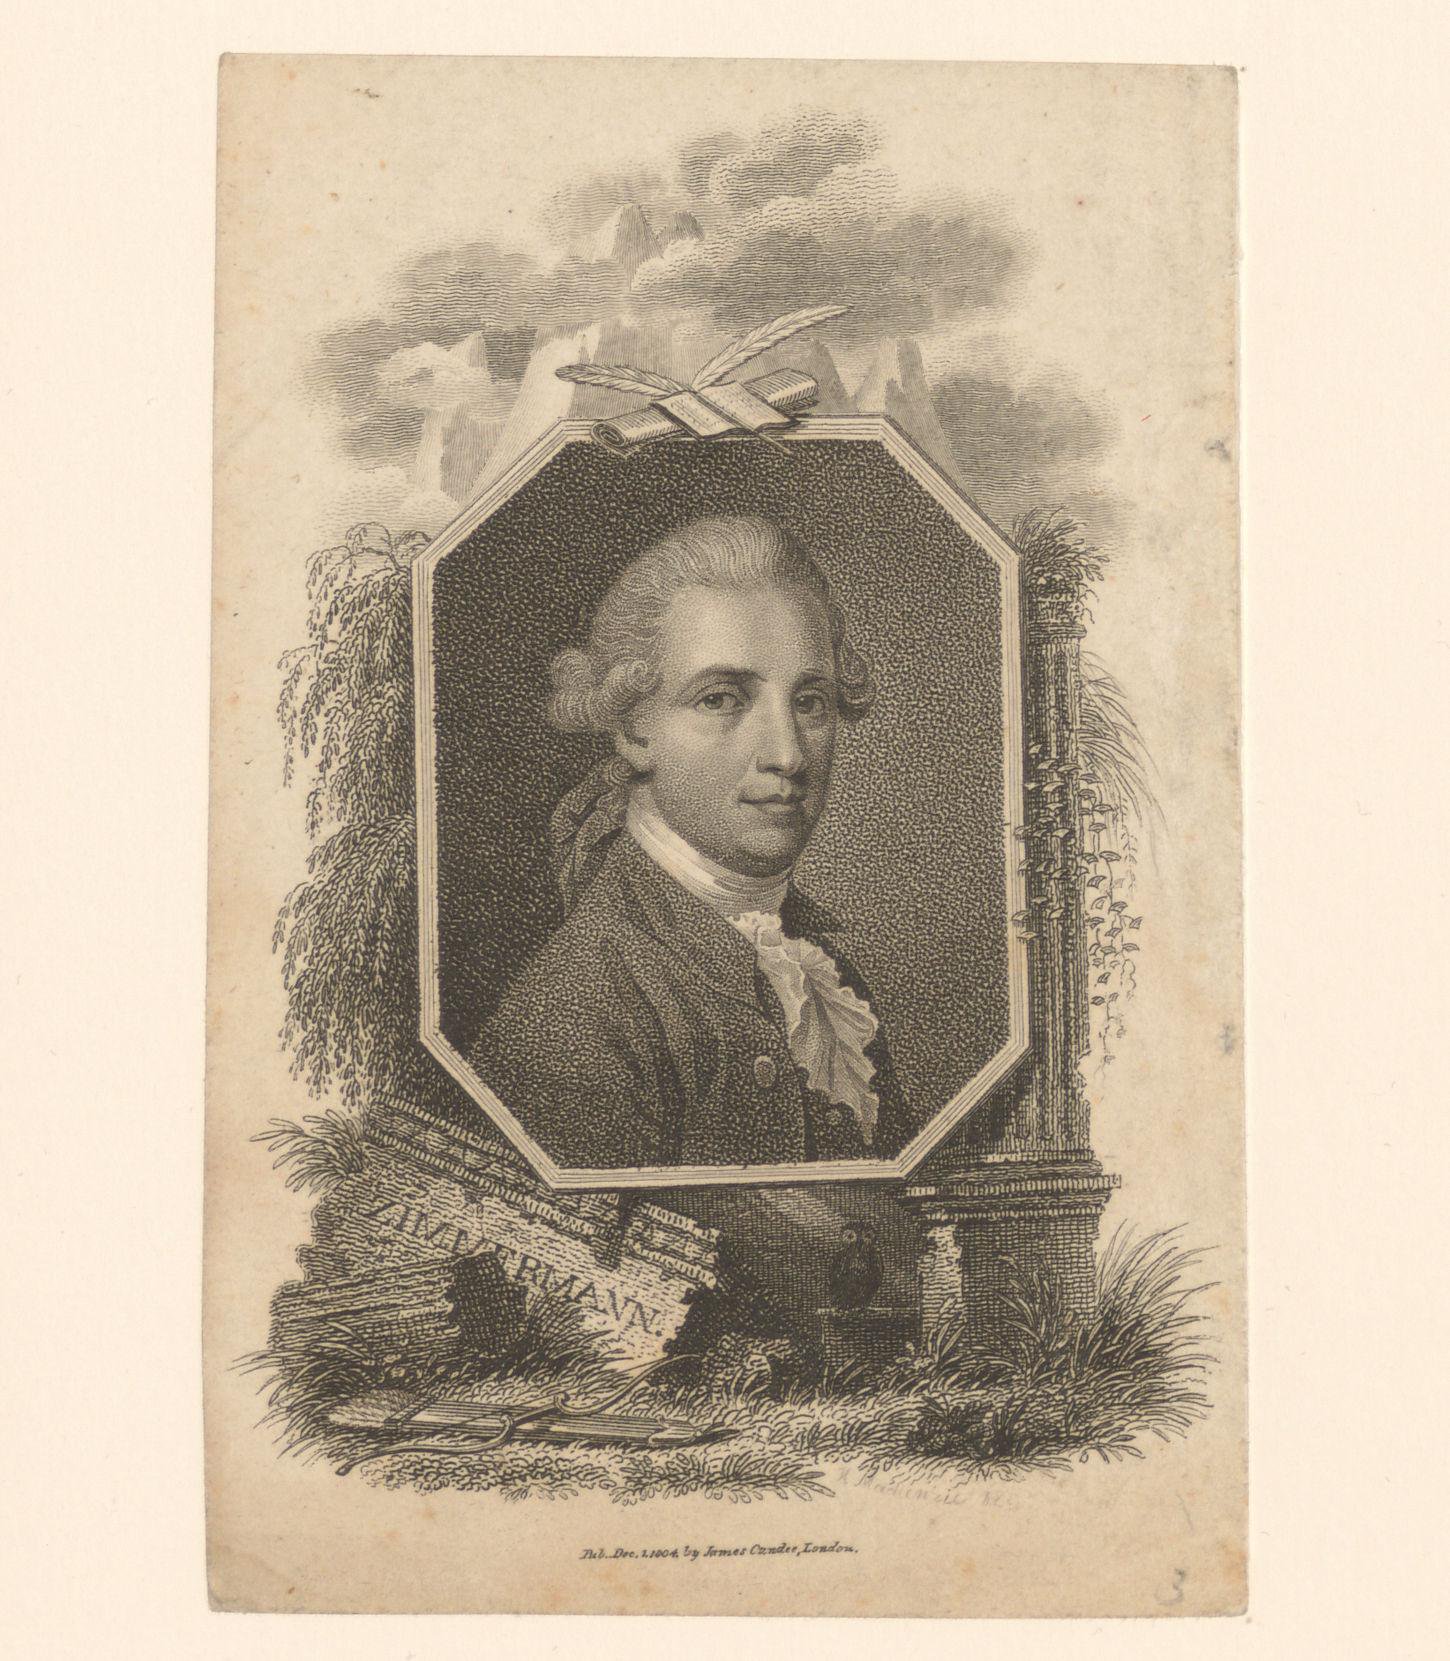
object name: print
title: Portret van Johann Georg Zimmermann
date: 1804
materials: paper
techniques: etching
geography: london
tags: historical persons, portrait of a writer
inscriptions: collector's mark: Lugt 2228